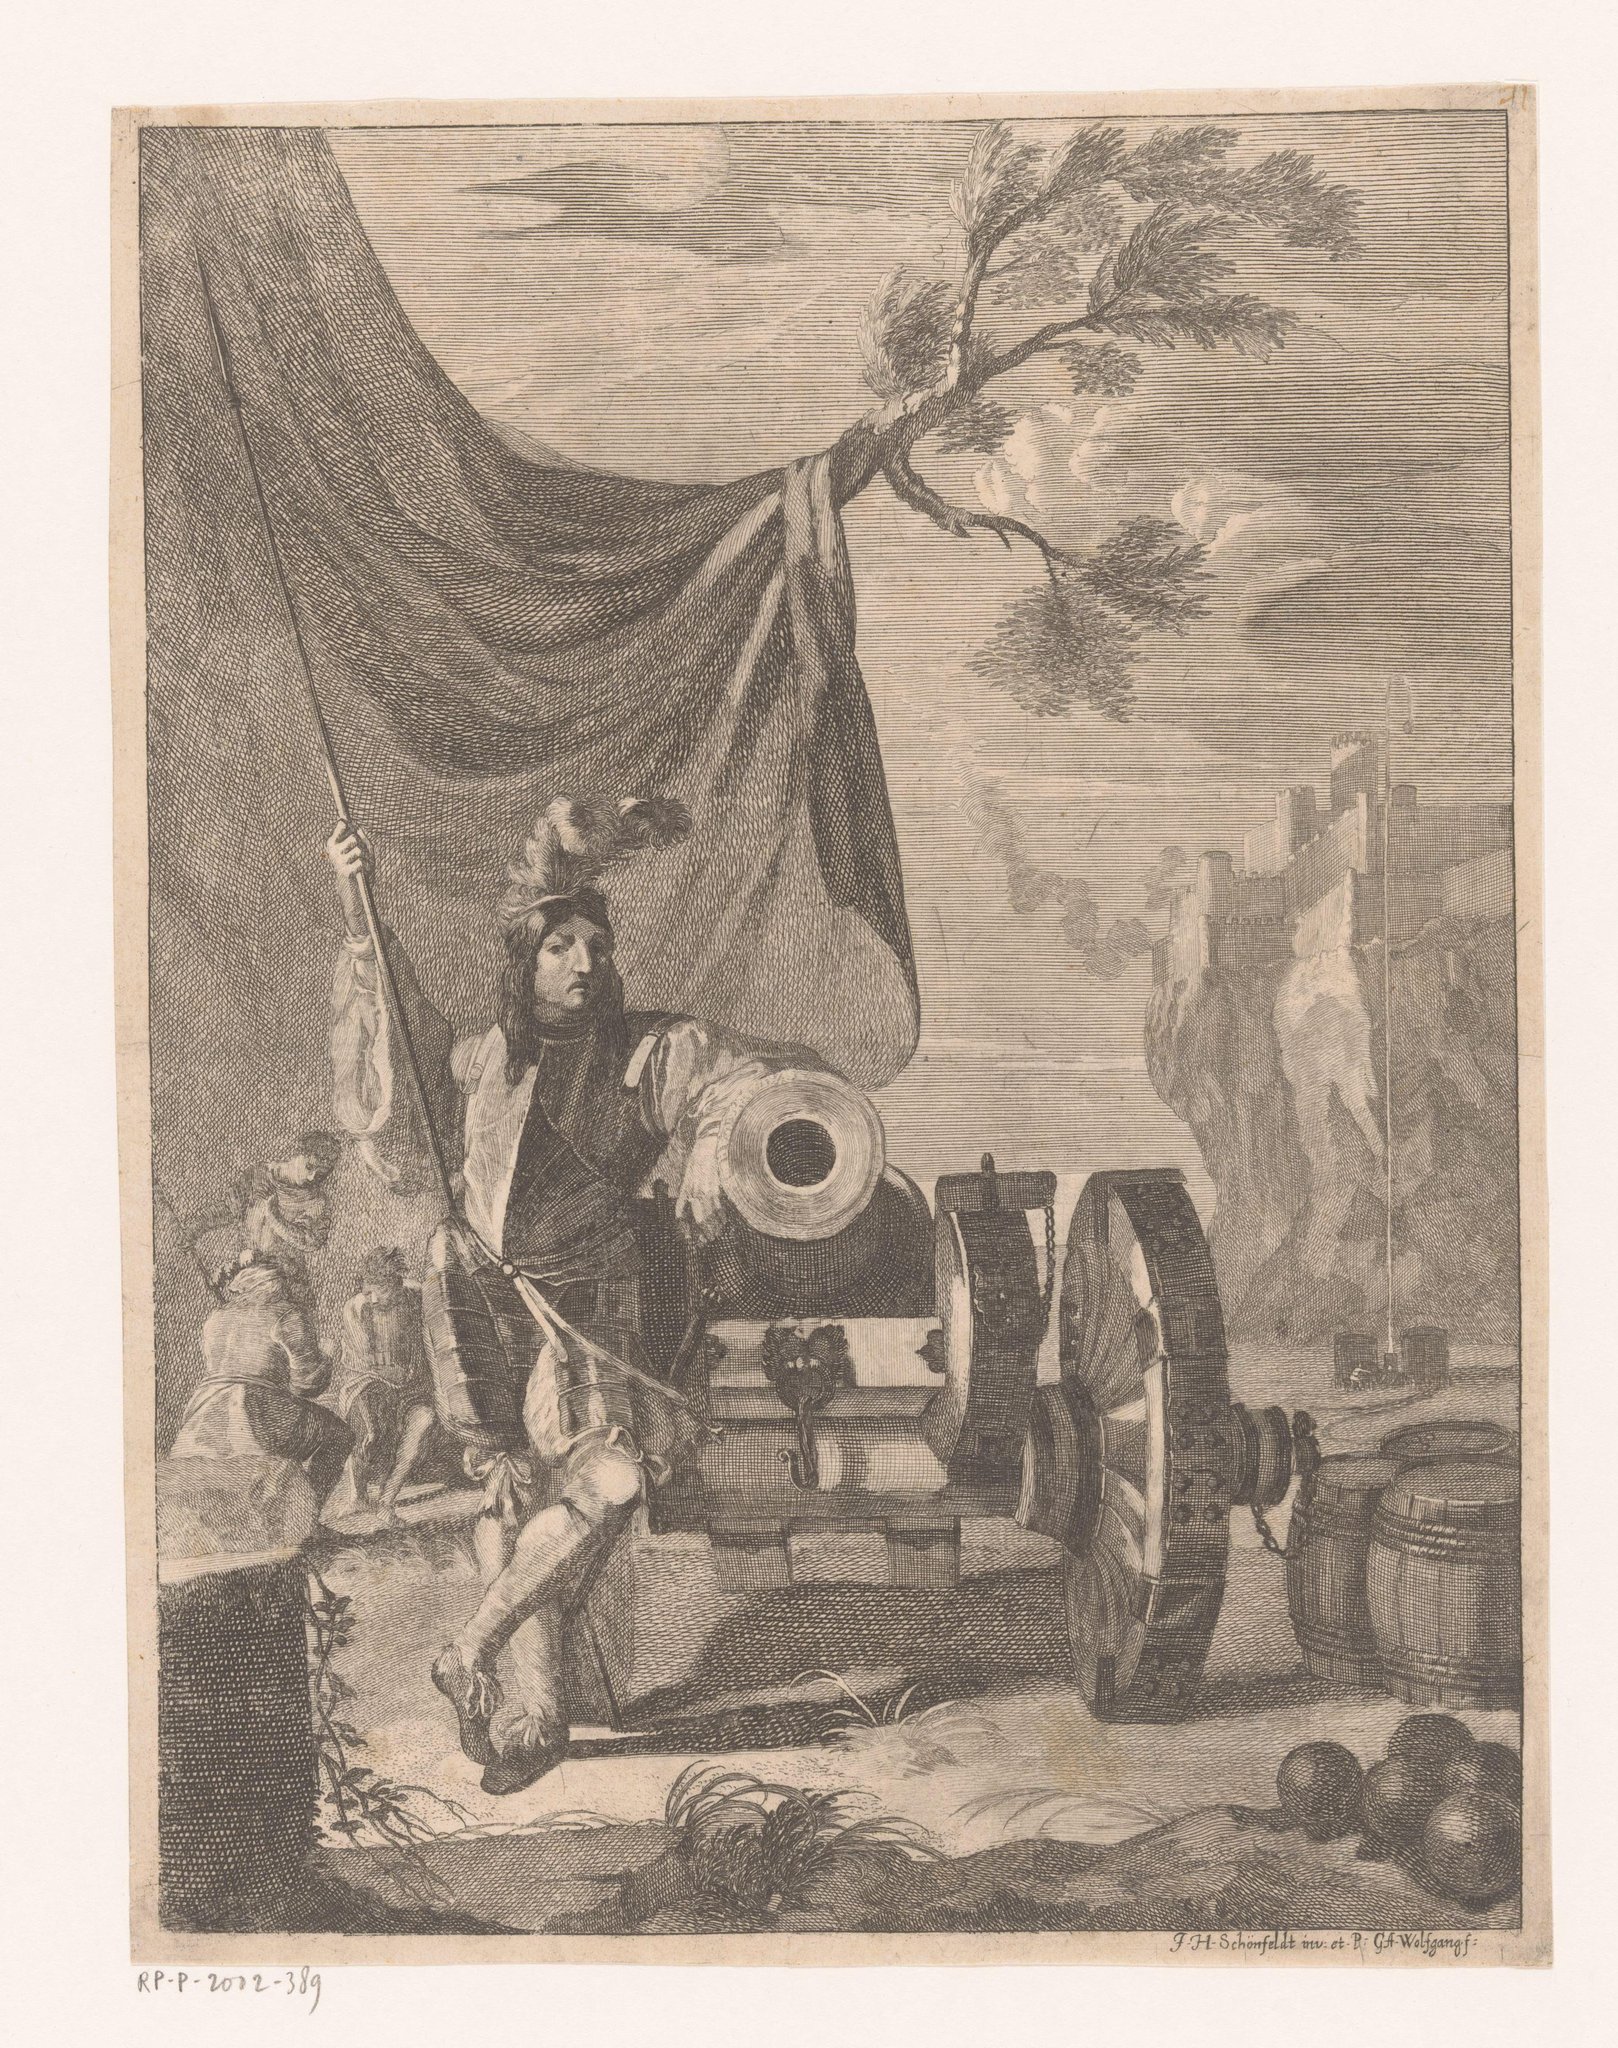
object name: print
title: Schutter bij een kanon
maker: georg andreas wolfgang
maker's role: goldsmith, print maker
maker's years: 1631-1716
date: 1641-1716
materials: paper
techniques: engraving, etching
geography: germany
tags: wooden container: barrel, cask, bucket, armour, firearms: cannon, projectiles, explosives, etc.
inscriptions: collector's mark: Lugt 2760, collector's mark: Lugt 2228